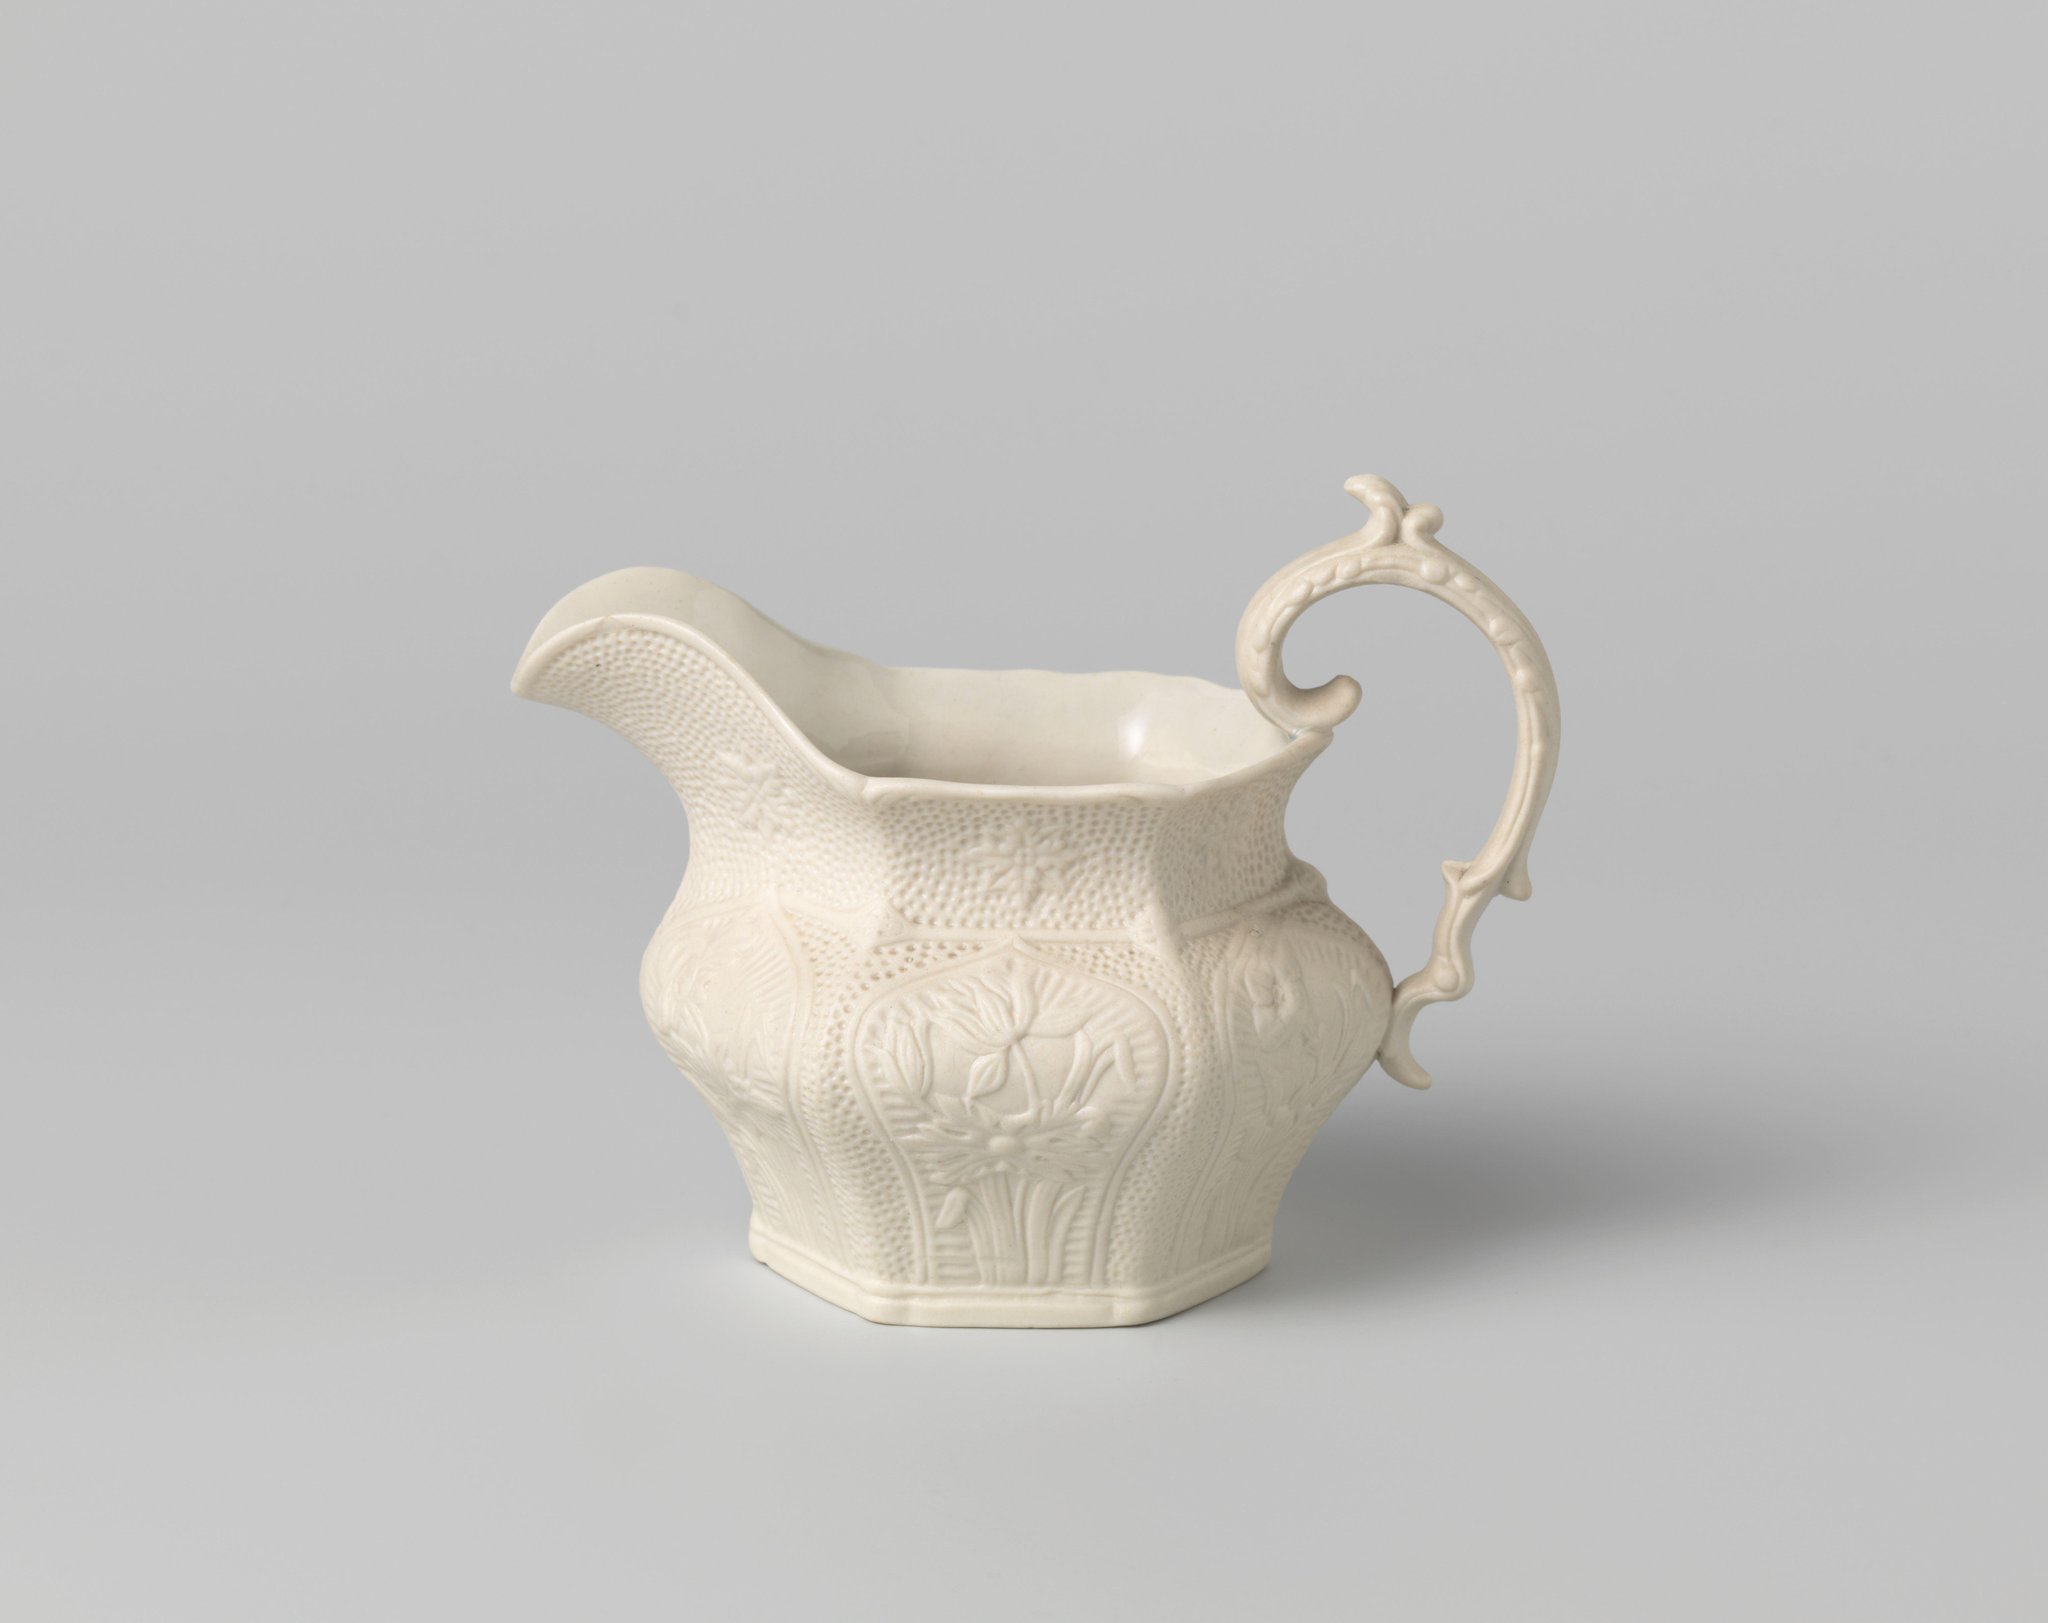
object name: milk jug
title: Melkkan, zeshoekig, gres blanc, met cartouches met bloemen in reliëf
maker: petrus regout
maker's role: plateelbakker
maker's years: 1801-1879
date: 1870-1890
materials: stoneware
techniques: vitrification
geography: maastricht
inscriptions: mark: ‘P. REGOUT // MAASTRICHT // 13’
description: Melkkan van geglazuurd aardewerk, gres blanc. Het zeshoekige lichaam is in reliëf gedecoreerd met zes ui-vormige cartouches met bloemen, tegen een gematteerde grond. Het c-vormige oor is opgebouwd uit gestileerde bladeren.